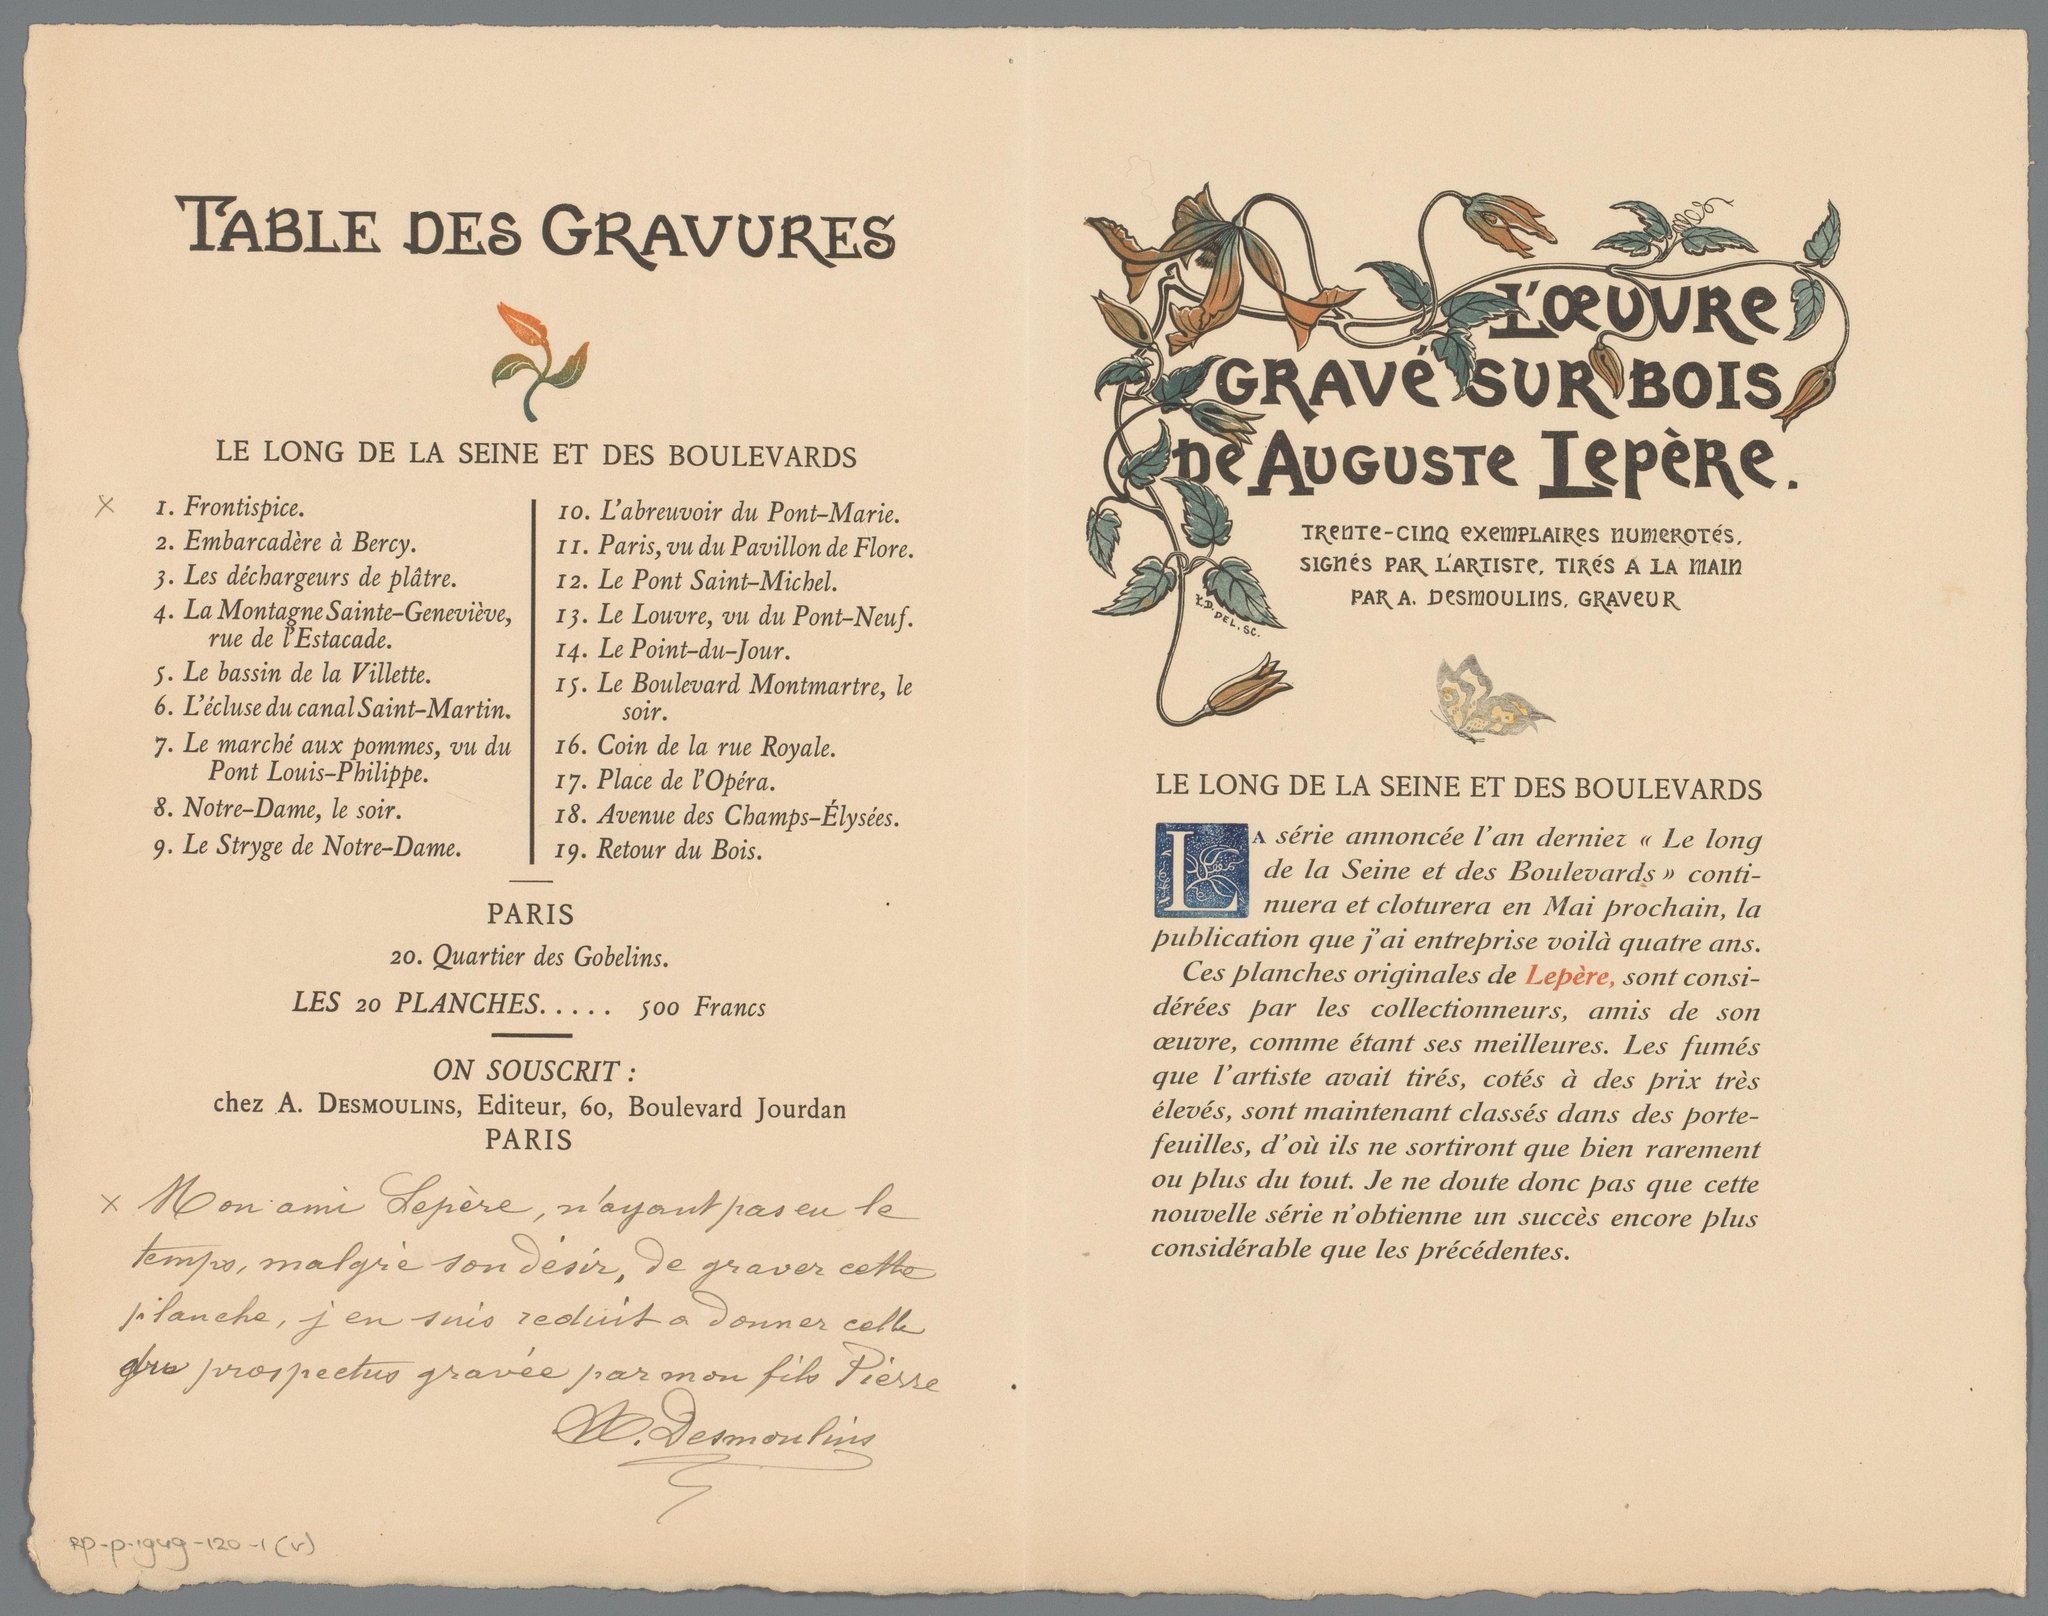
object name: print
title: Le long de la Seine et des boulevards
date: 1910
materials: paper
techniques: letterpress printing, engraving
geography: paris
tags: initial, insects: butterfly, flowers ~ ornament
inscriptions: inscription: ‘Mon ami Lepère, n'ayant pas eu le temps, malgré son désir, de graver cette plance, j'en suis reduit a donner cette prospectus gravée par mon fils Pierre. A. Desmoulins’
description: Deze serie heeft als titel 'Le Long de la Seine et des boulevards'. Deze serie is het vierde deel van het grotere geheel 'L'Oeuvre gravé sur bois de Auguste Lepère'.